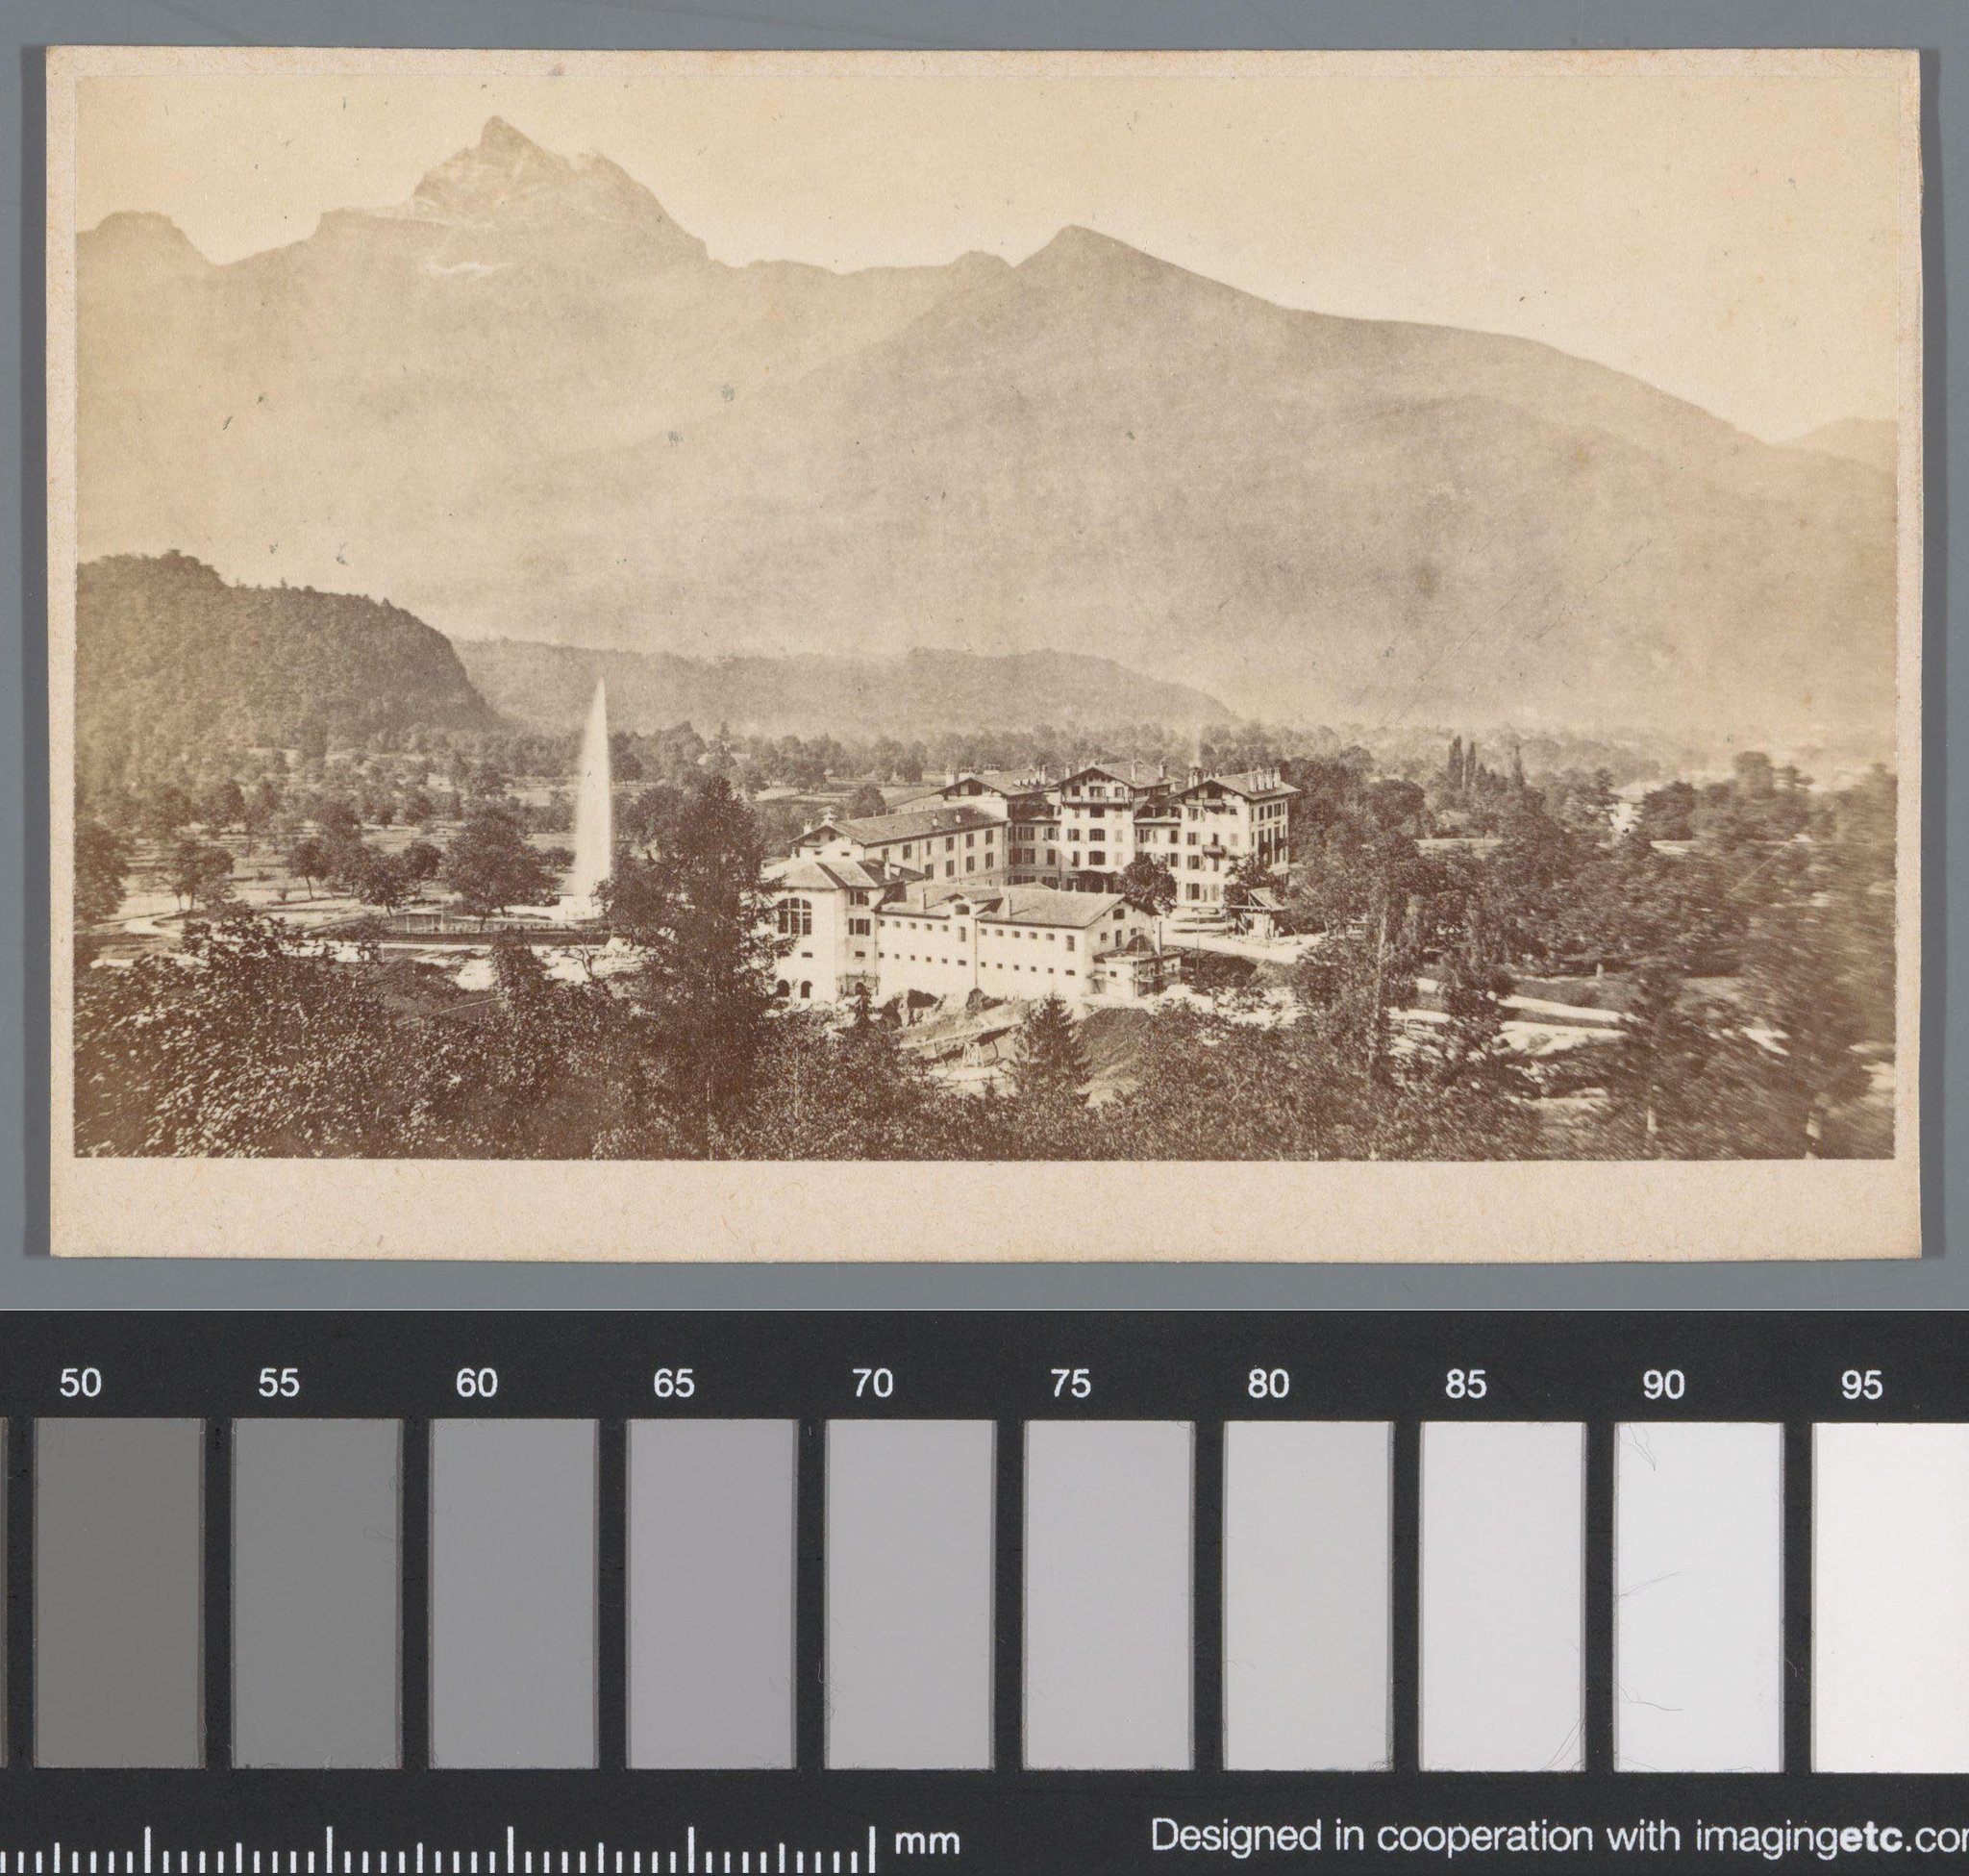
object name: carte de visite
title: Besc.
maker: Anonymous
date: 1855-1885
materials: cardboard, paper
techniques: albumen print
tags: prospect of village, silhouette of village